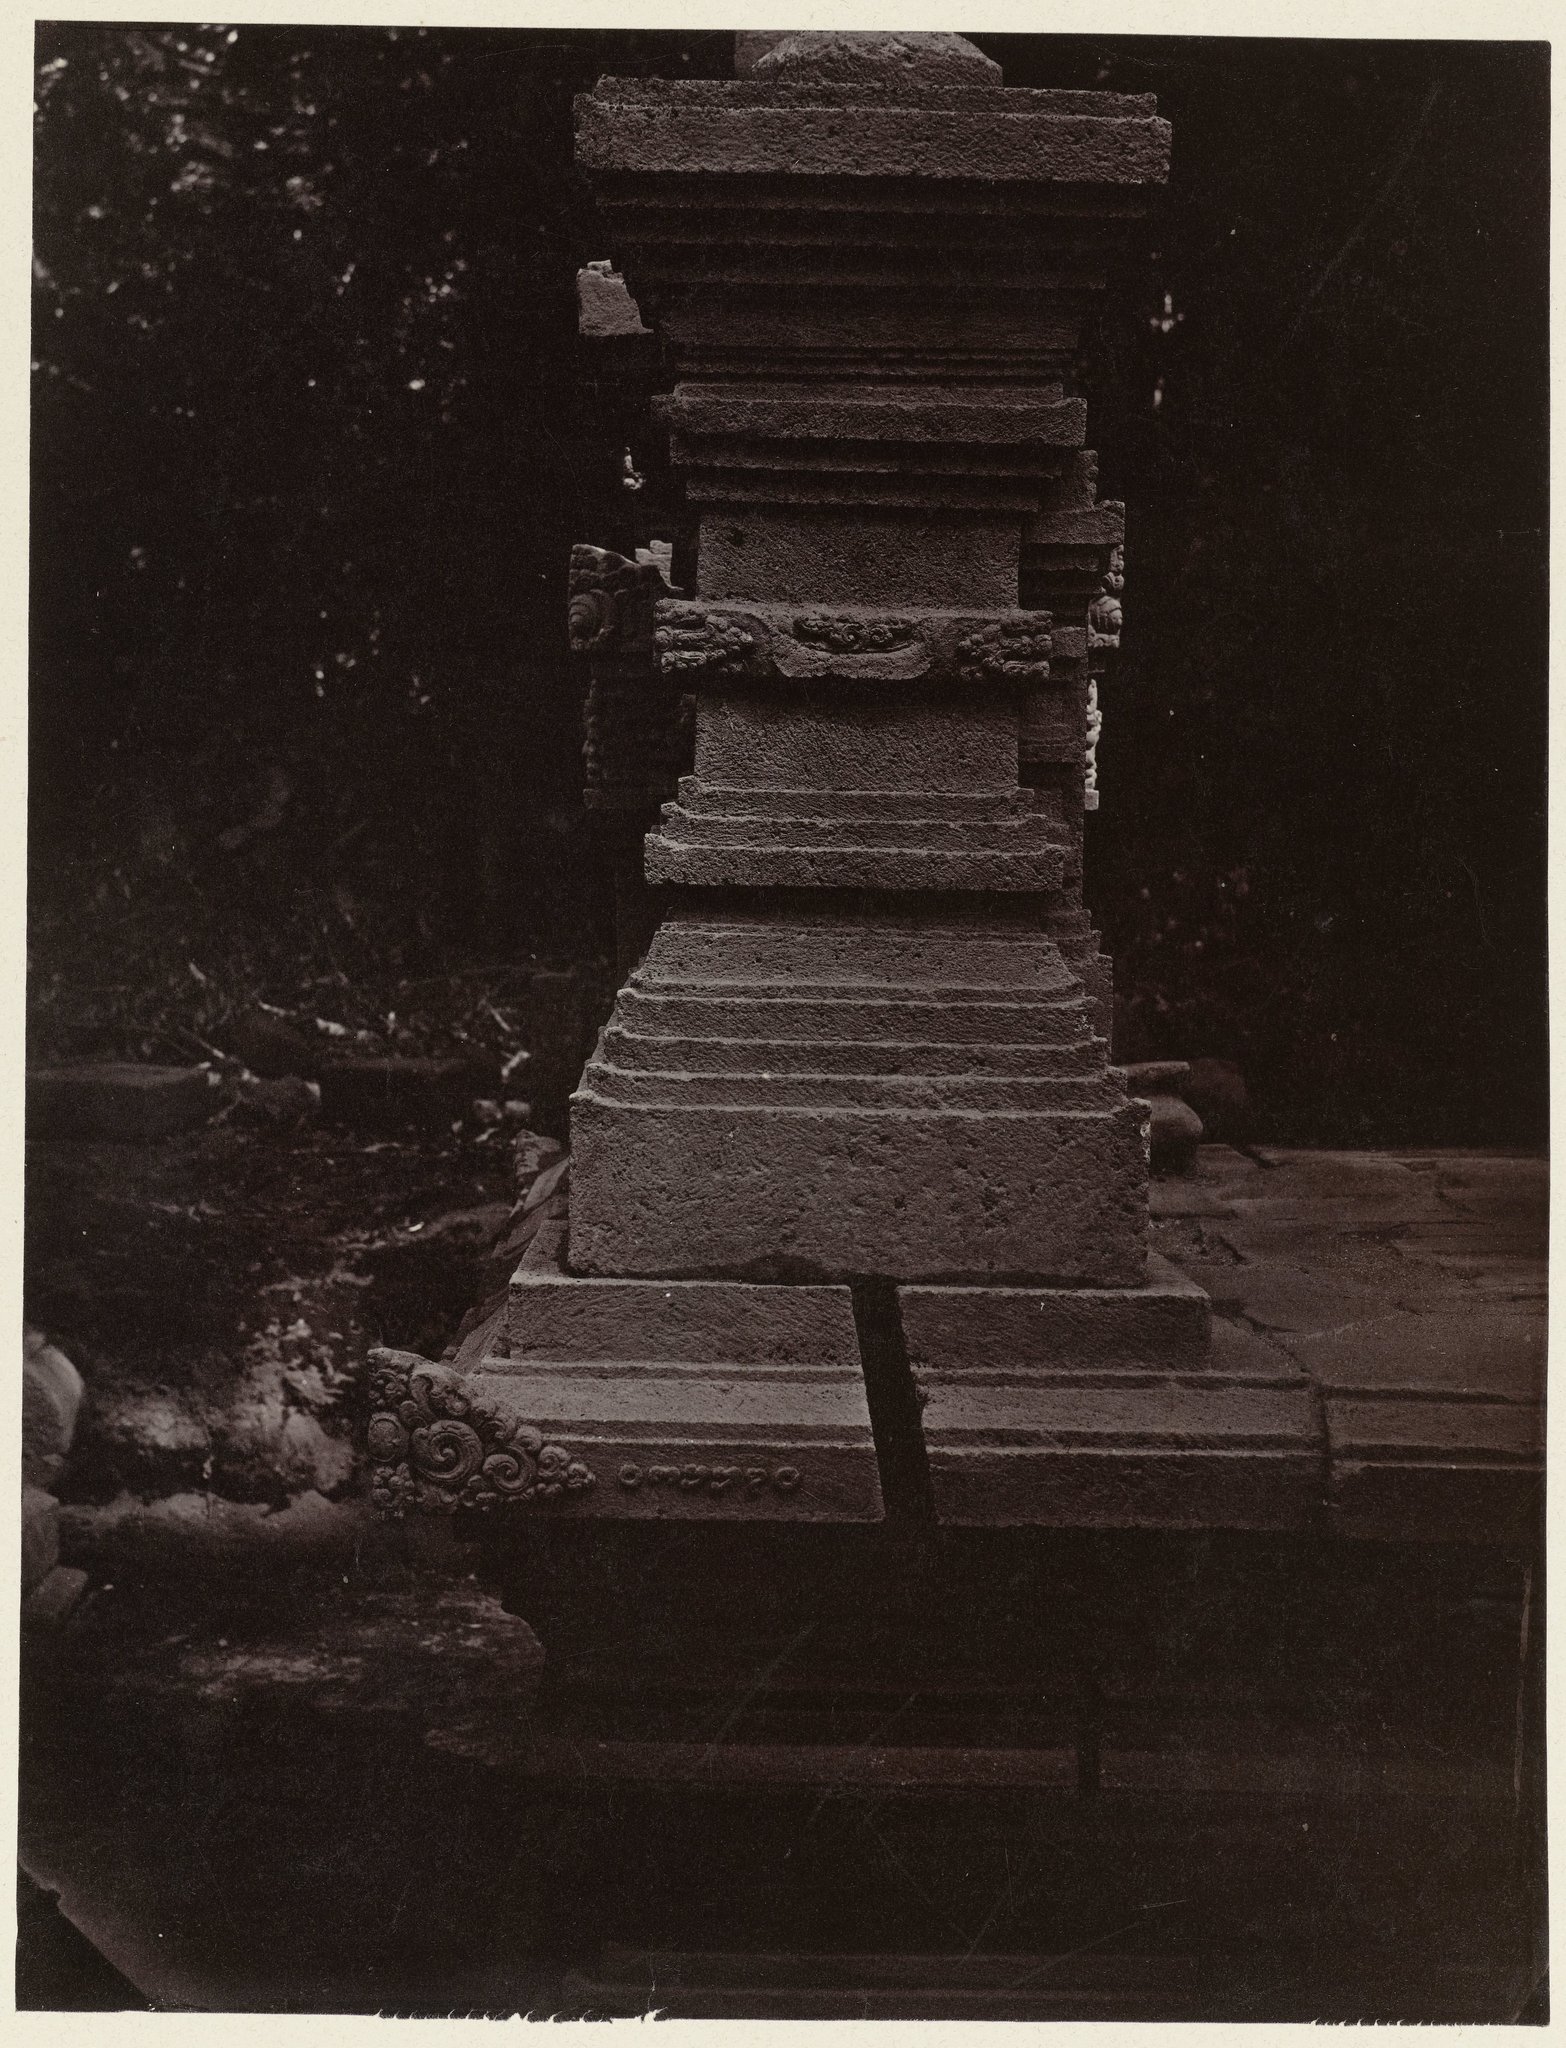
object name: photograph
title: Candi Papoh/Kotes, platform miniature temple with kalamukha ornaments, rear view. Gandusari, Blitar district, East Java province, 13th-14th century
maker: isidore kinsbergen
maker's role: fotograaf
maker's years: 1821-1905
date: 1807-1867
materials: cardboard, paper, photographic support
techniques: albumen print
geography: java